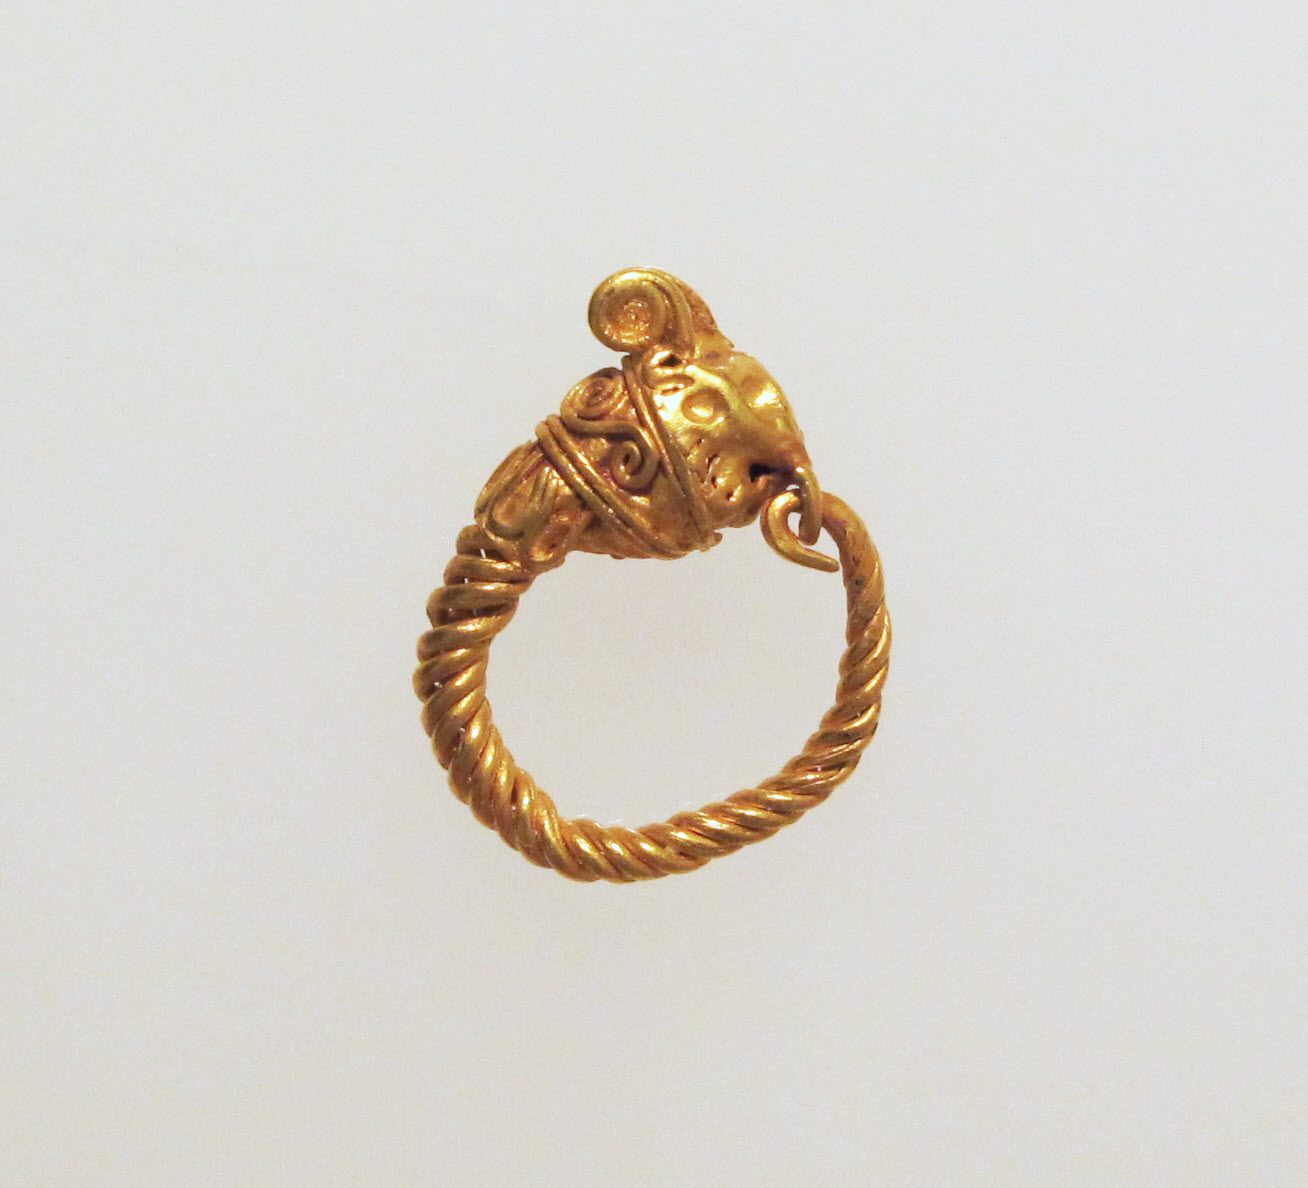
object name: earring with head of goat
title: Gold earring with head of an animal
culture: greek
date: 400-201 BCE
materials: gold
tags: animals